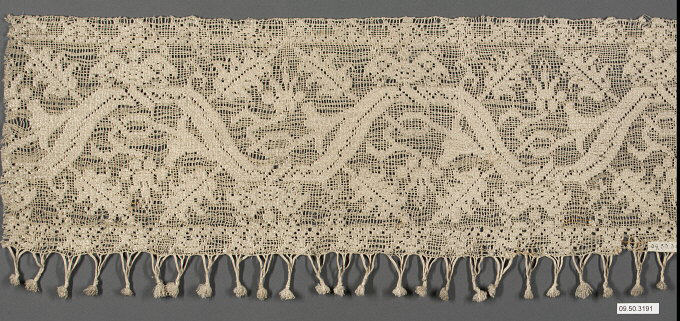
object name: edging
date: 1501-1600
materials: silk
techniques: embroidery